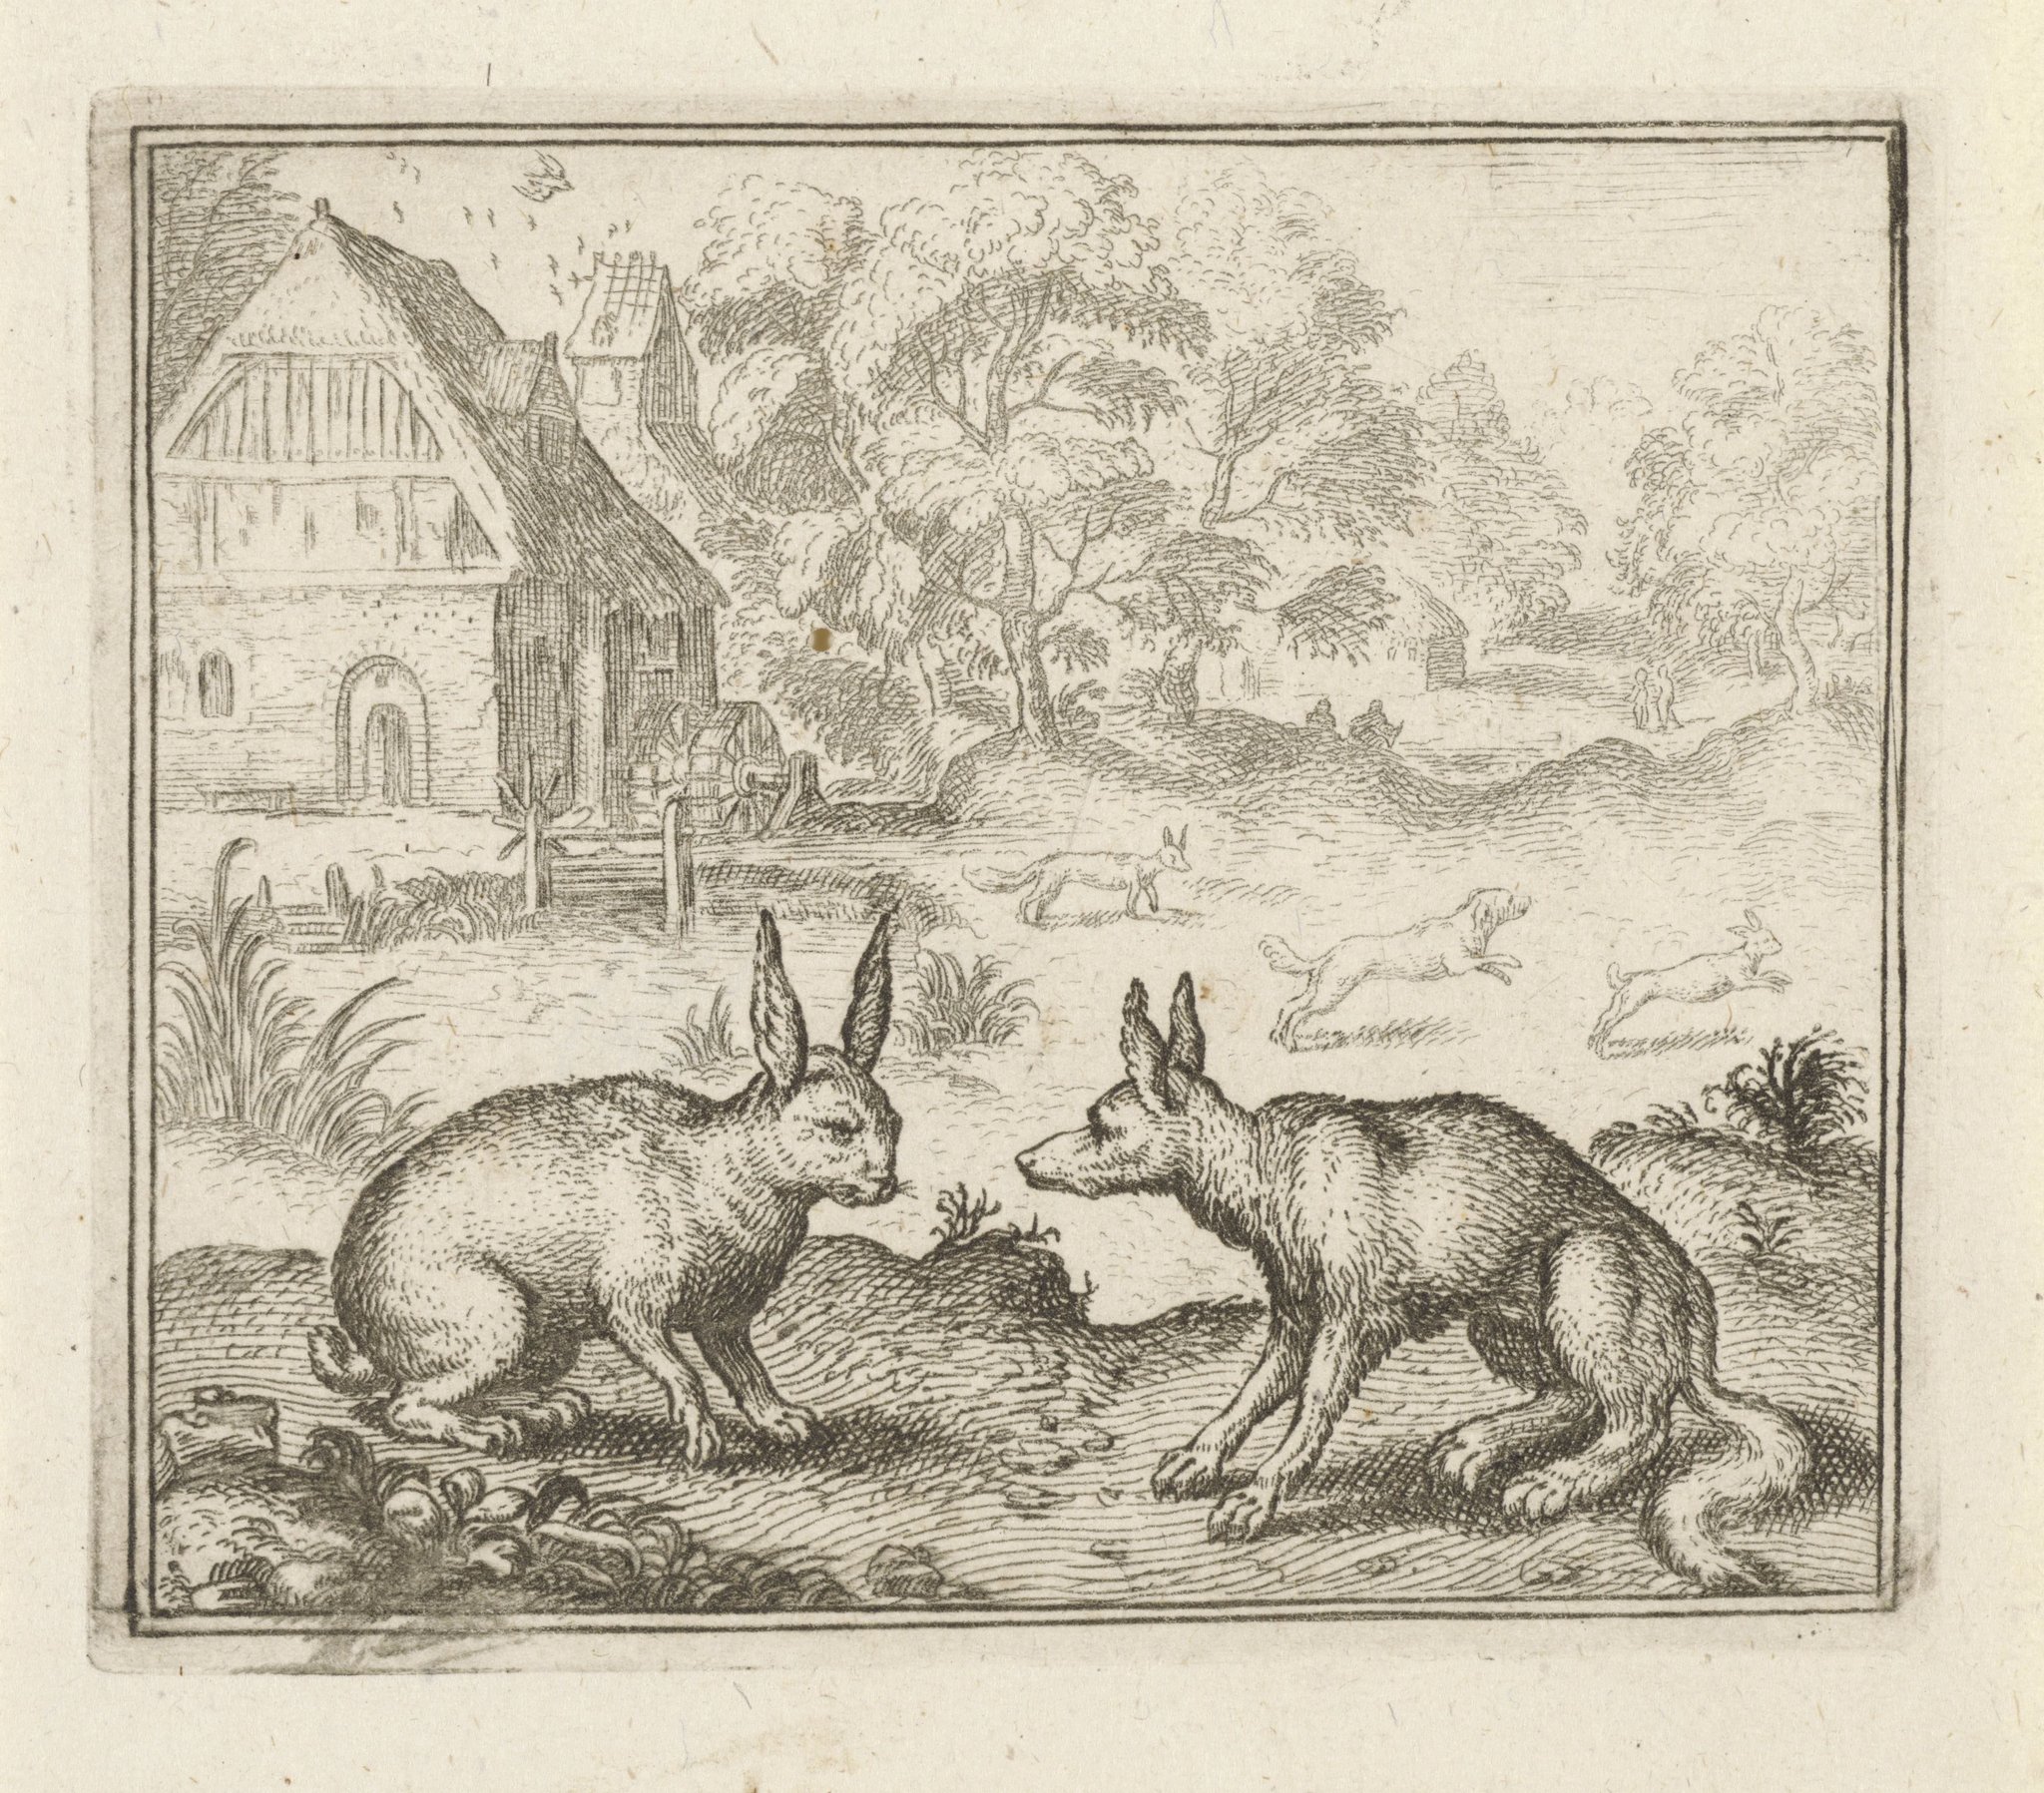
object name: print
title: Fabel van de vos, de hond en de haas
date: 1608-1679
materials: paper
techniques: etching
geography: prague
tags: rodents: hare, fables, dog, beasts of prey, predatory animals: fox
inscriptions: collector's mark: Lugt 2228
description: Op de voorgrond een vos en een haas. Op de achtergrond rent een hond achter een haas terwijl de vos toekijkt. De fabel beschrijft hoe de vos door een hond met de dood wordt bedreigd. Hij overtuigt de hond op een haas te gaan jagen. De moraal van het verhaal waarschuwt voor slechte vrienden.